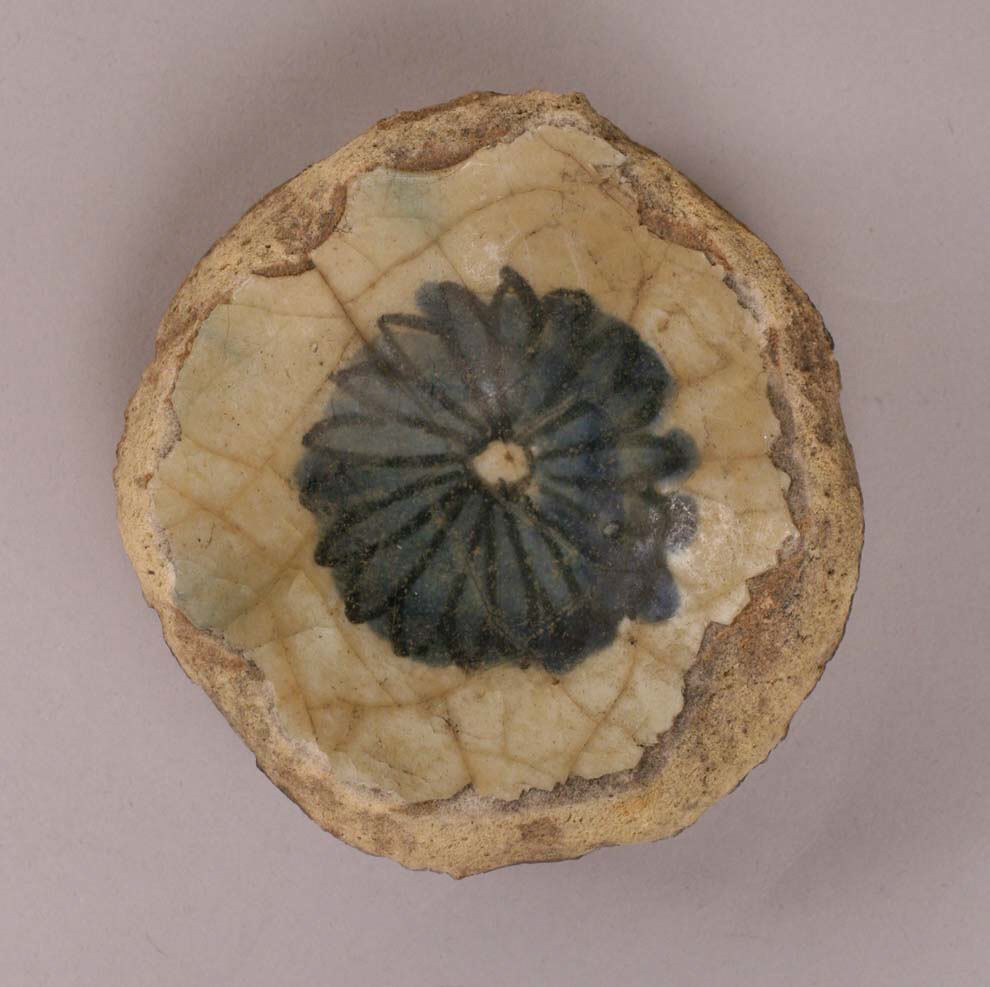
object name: fragment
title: Fragment of a Bowl or Cup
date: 1201-1600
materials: glaze, stonepaste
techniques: painting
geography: egypt